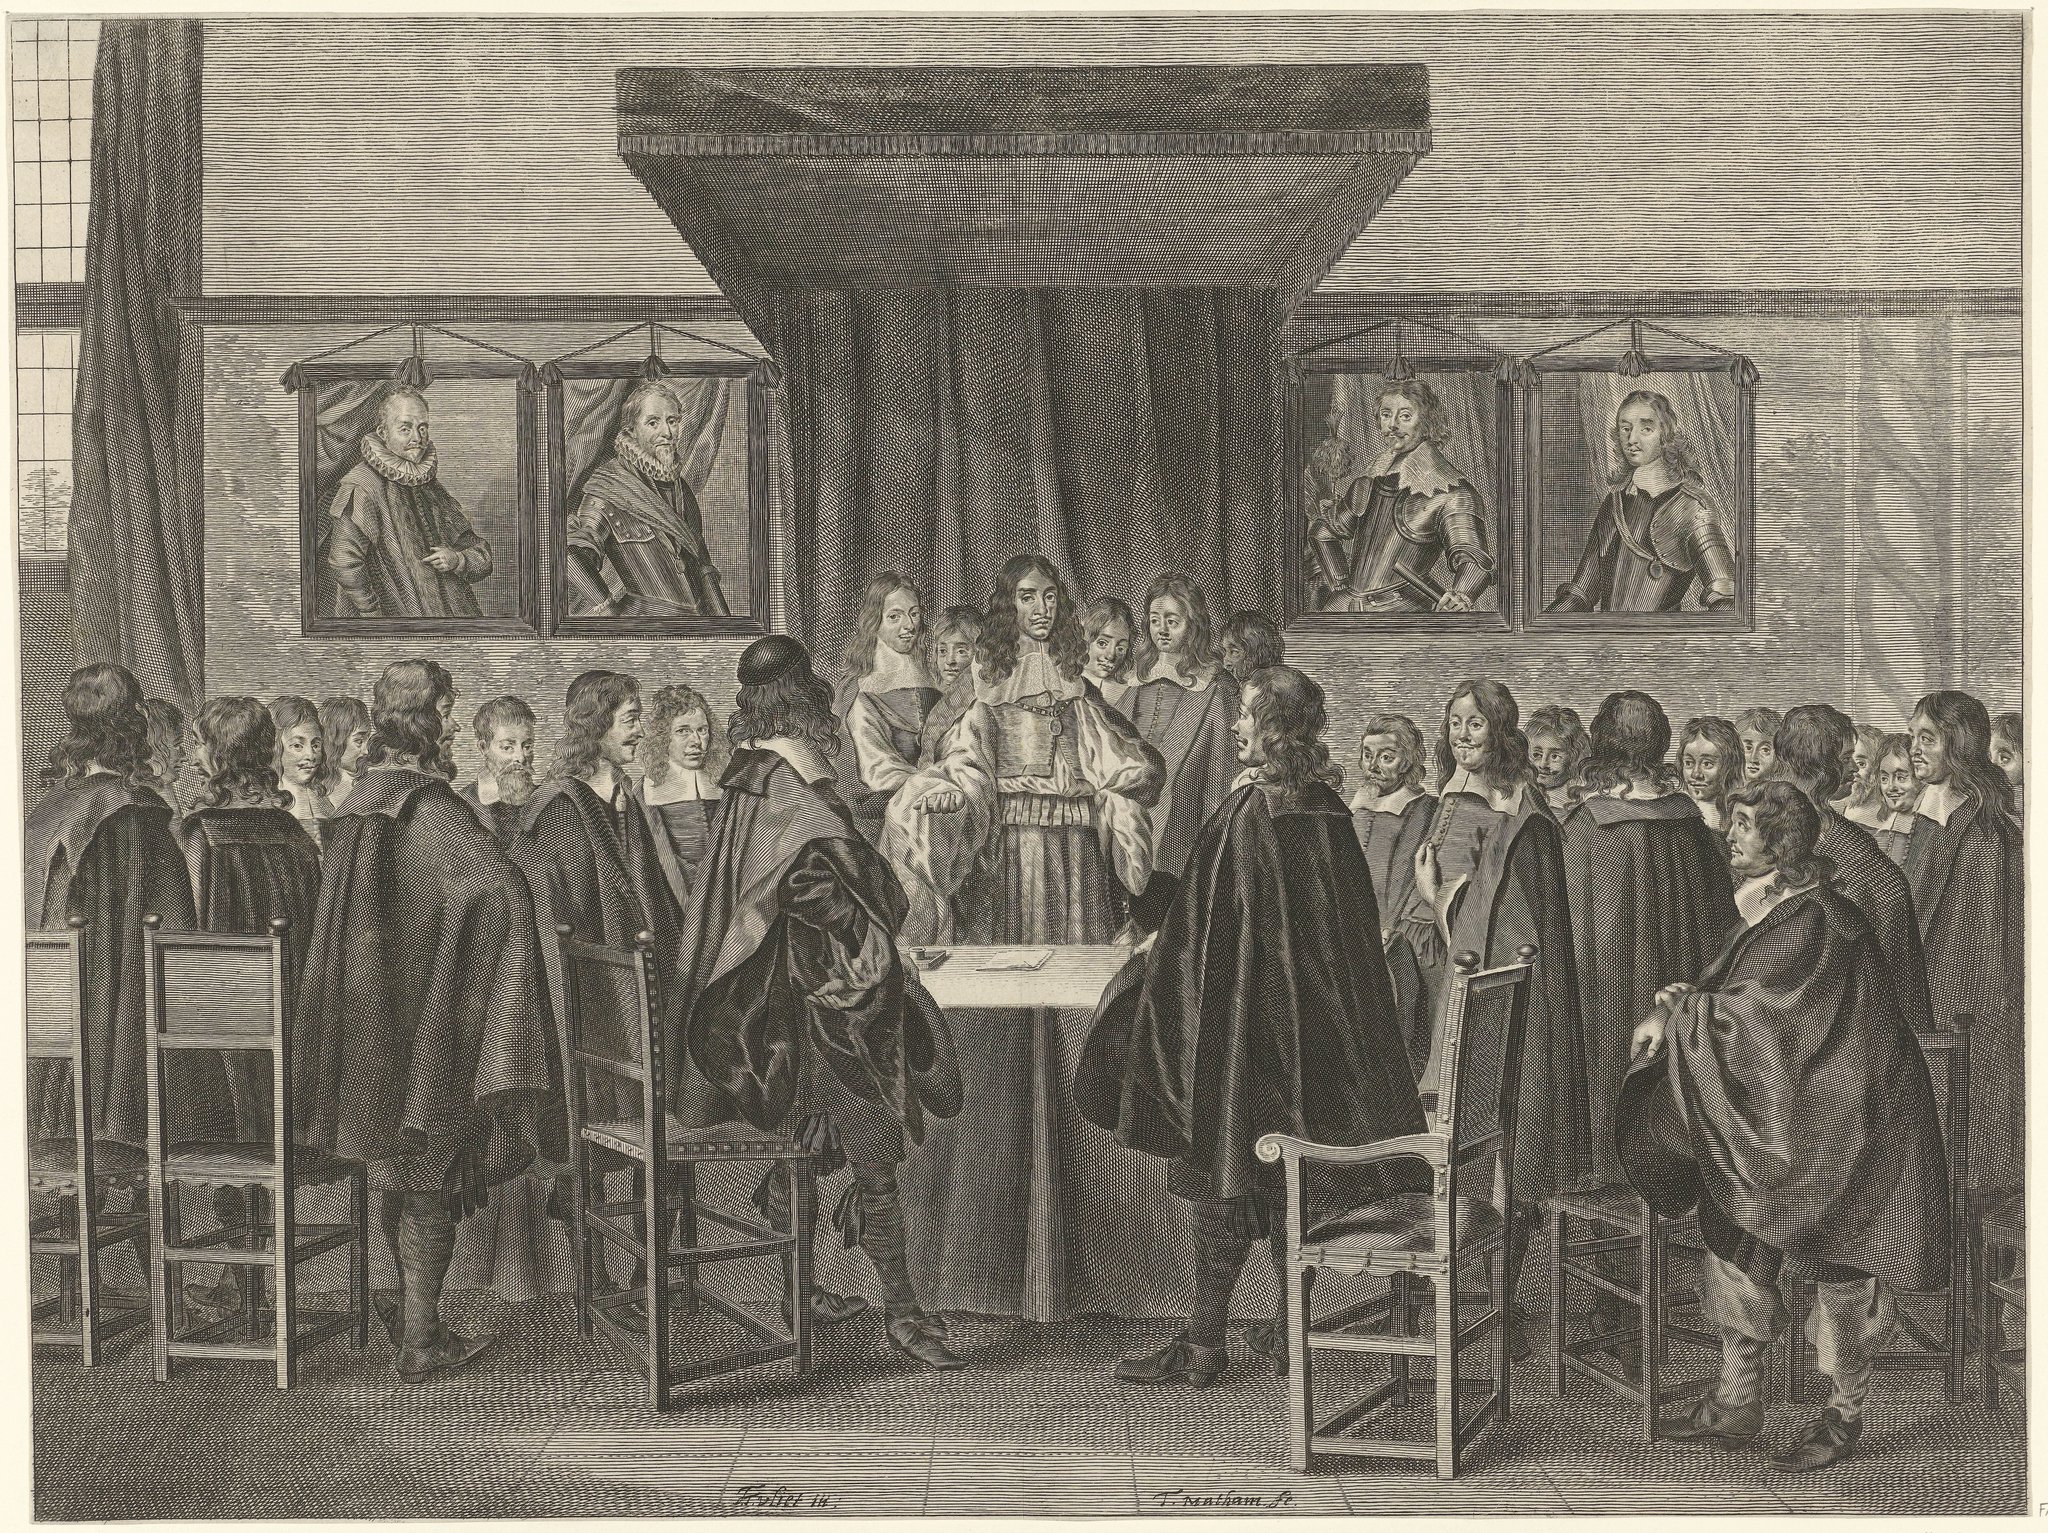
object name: print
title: Koning Karel II van Engeland spreekt de staande leden van de Staten-Generaal toe, 1660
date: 1660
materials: paper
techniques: engraving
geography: northern netherlands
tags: karel ii (koning van engeland), festivities (+ speech, address ~ festive activities)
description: Koning Karel II van Engeland spreekt een kleine groep staande leden van de Staten-Generaal toe, 1 juni 1660. Episode tijdens zijn rondreis door en vertrek uit de Nederlanden. De koning staande achter een tafel, aan de muur portretten van de stadhouders Willem I, Maurits, Frederik Hendrik en Willem II.